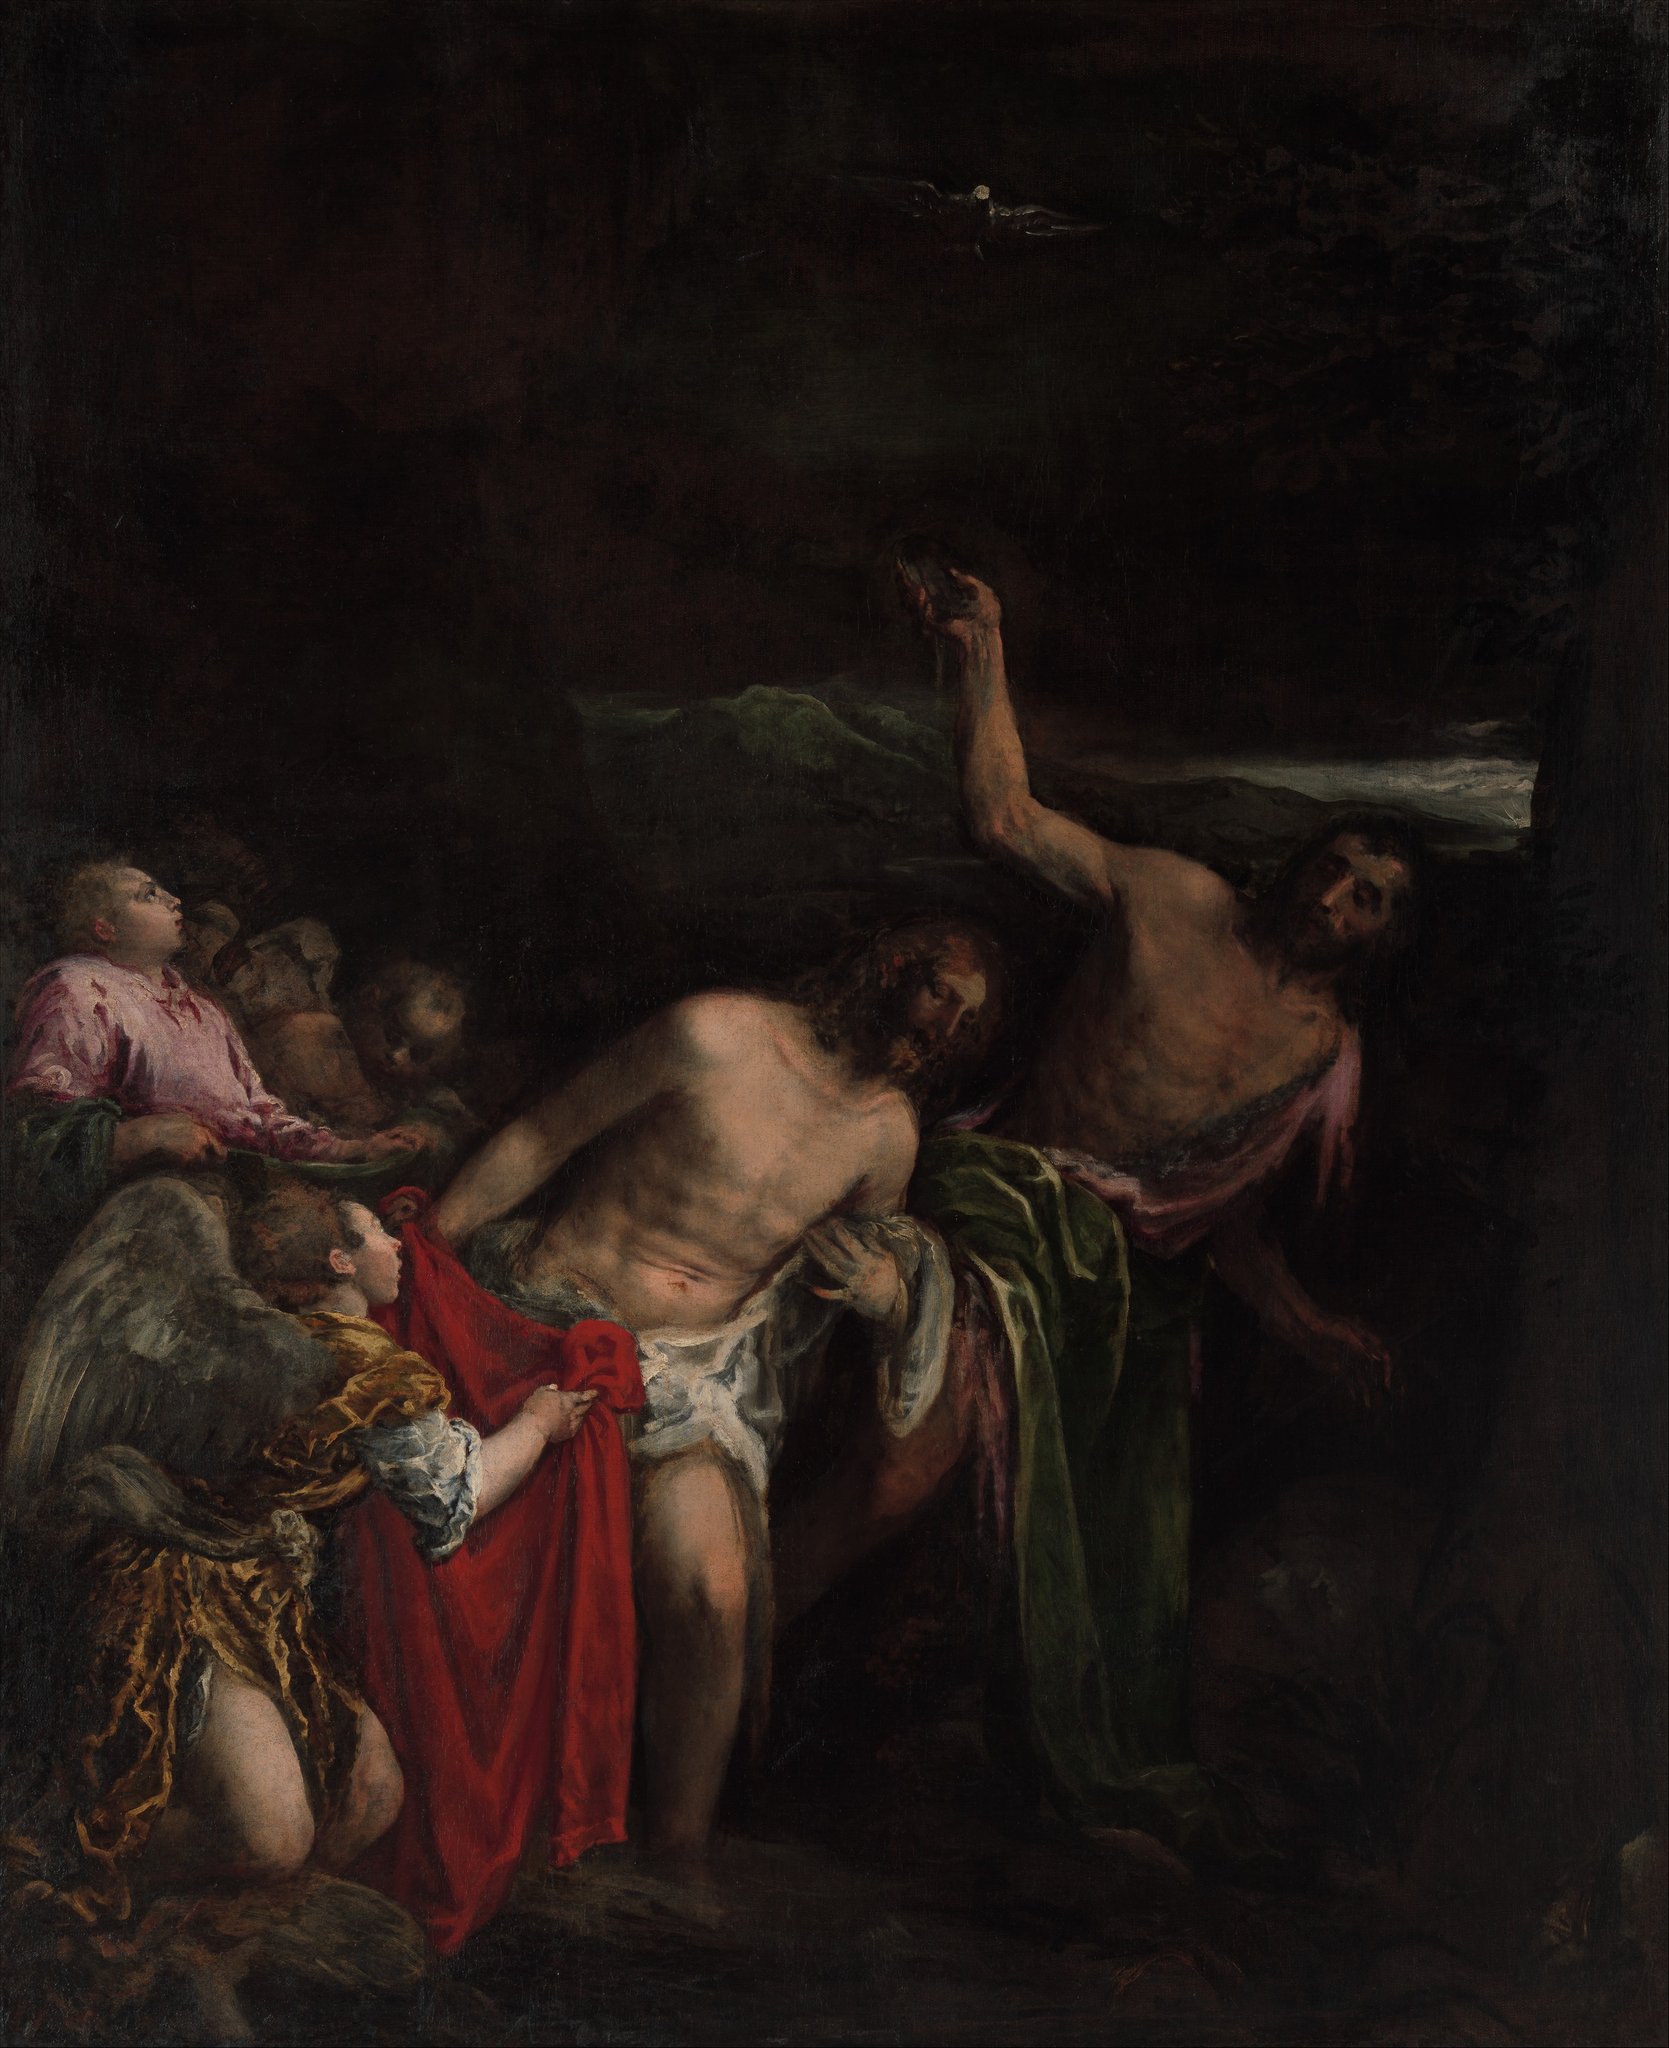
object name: painting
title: The Baptism of Christ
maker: jacopo bassano (jacopo da ponte)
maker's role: artist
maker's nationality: italian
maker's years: 1510-1592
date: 1590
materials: canvas, oil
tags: men,angels,saint john the baptist,baptism of christ